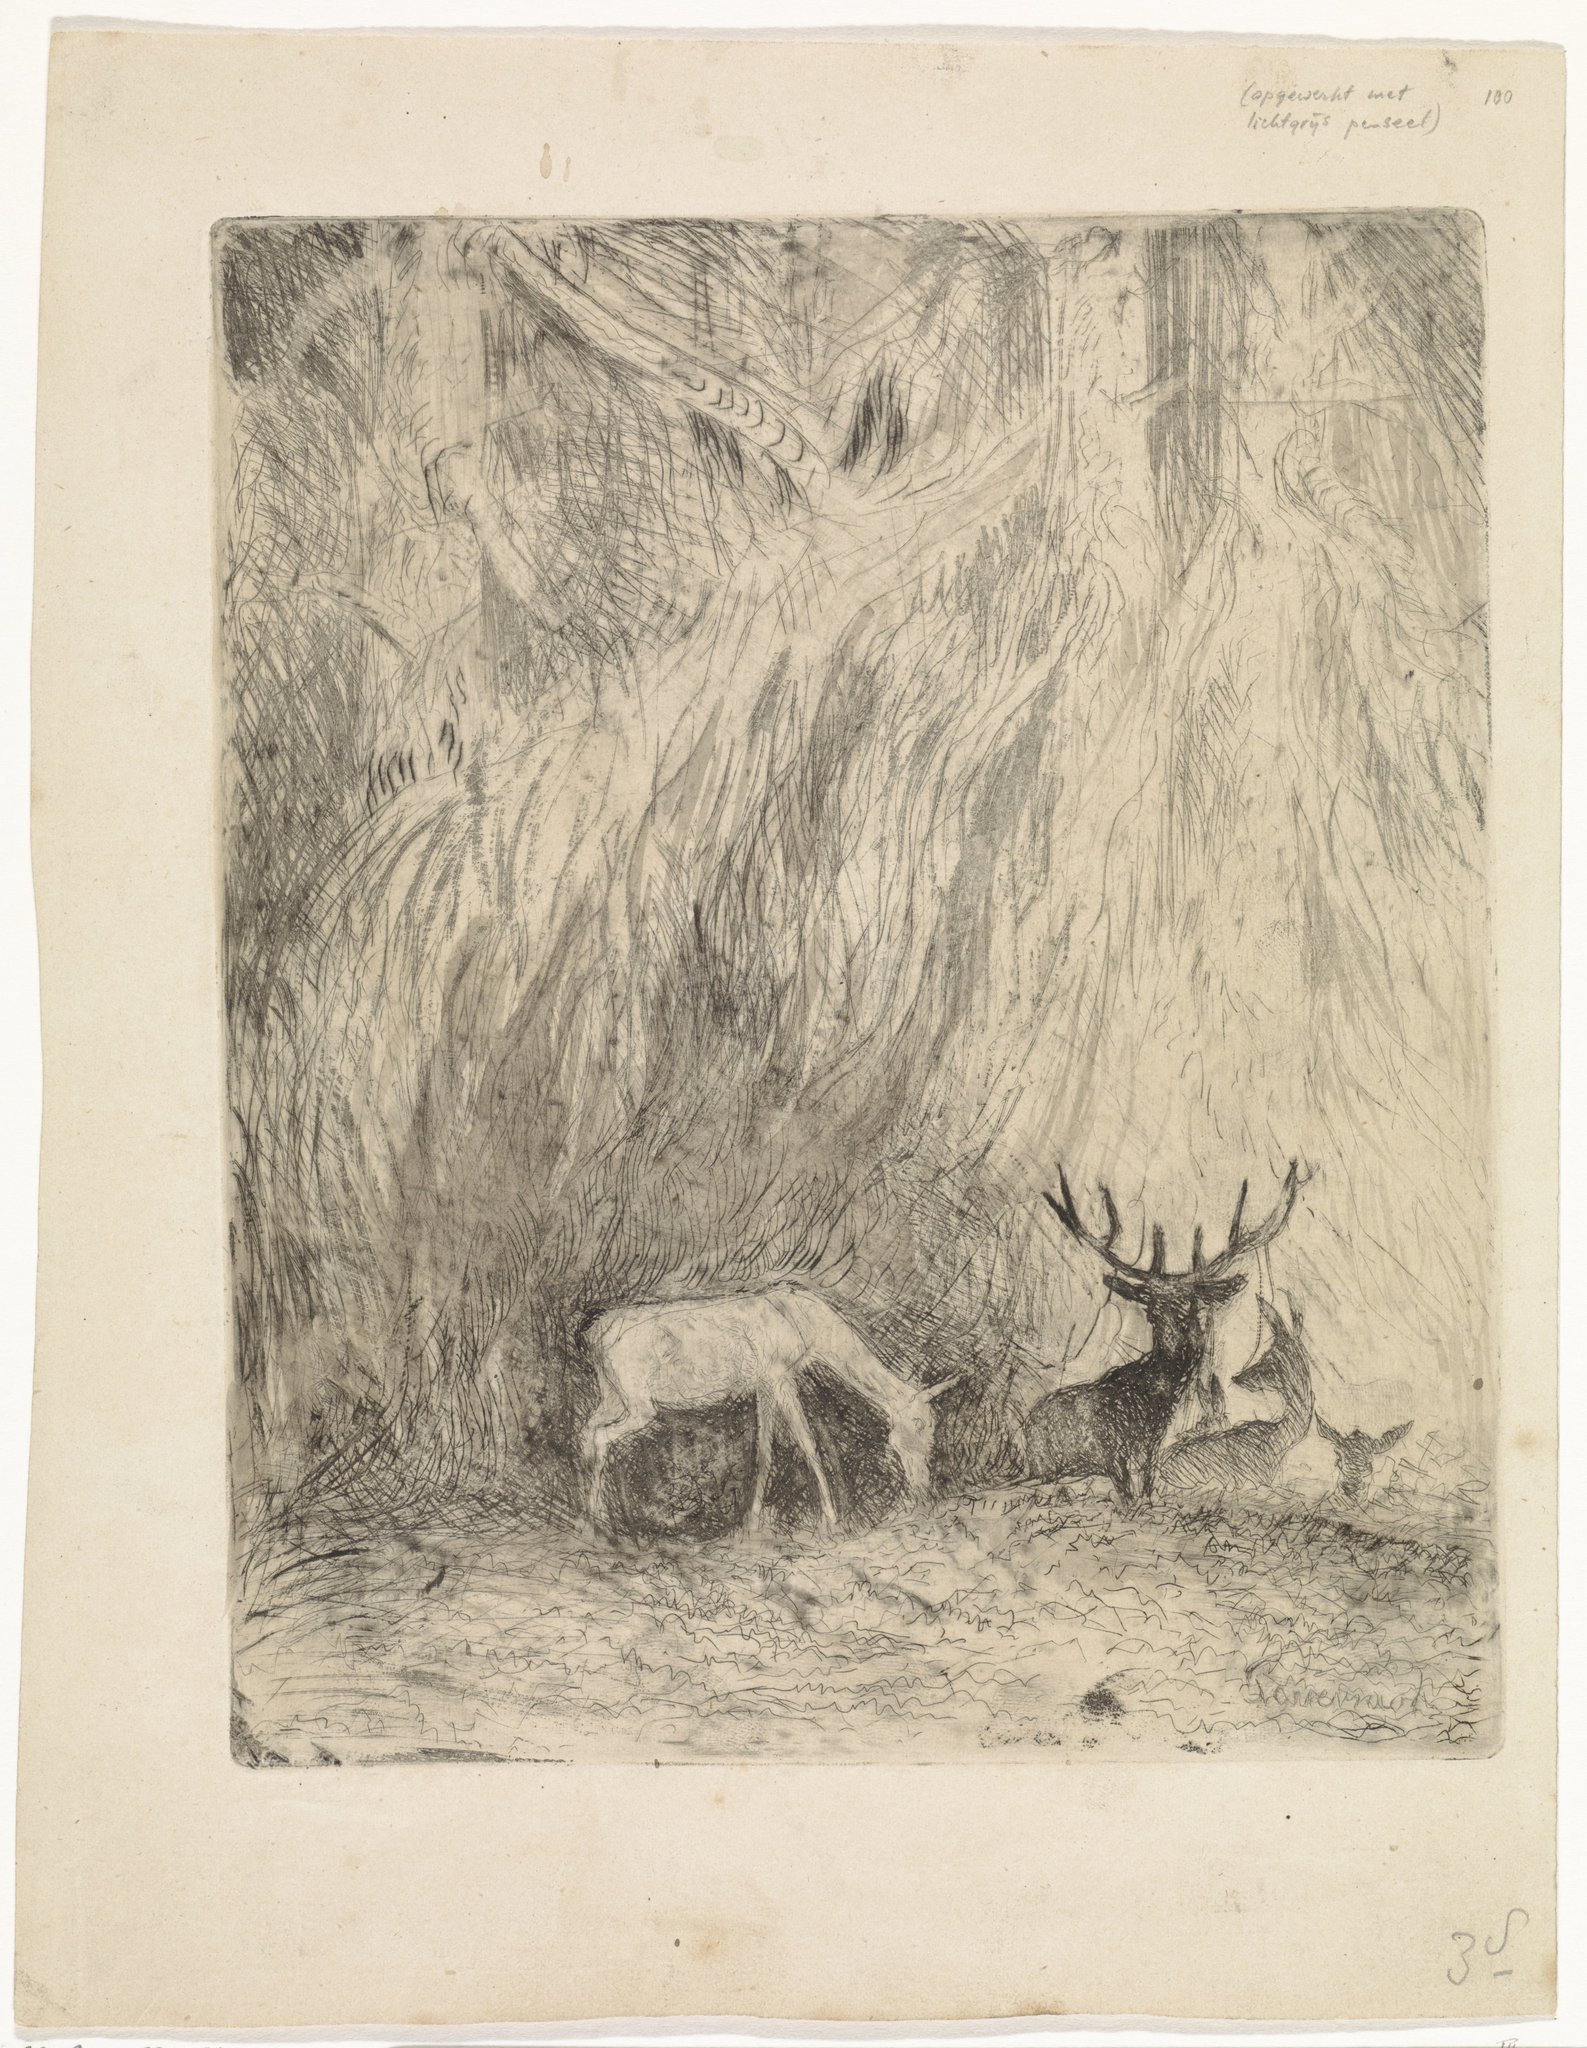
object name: print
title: Herten in een Boheems woud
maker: johannes tavenraat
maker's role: draughtsman, painter, print maker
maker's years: 1809-1881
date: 1819-1881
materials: paper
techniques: etching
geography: cleves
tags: hoofed animals: deer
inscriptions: collector's mark: Lugt 2228, collector's mark: Lugt 2760